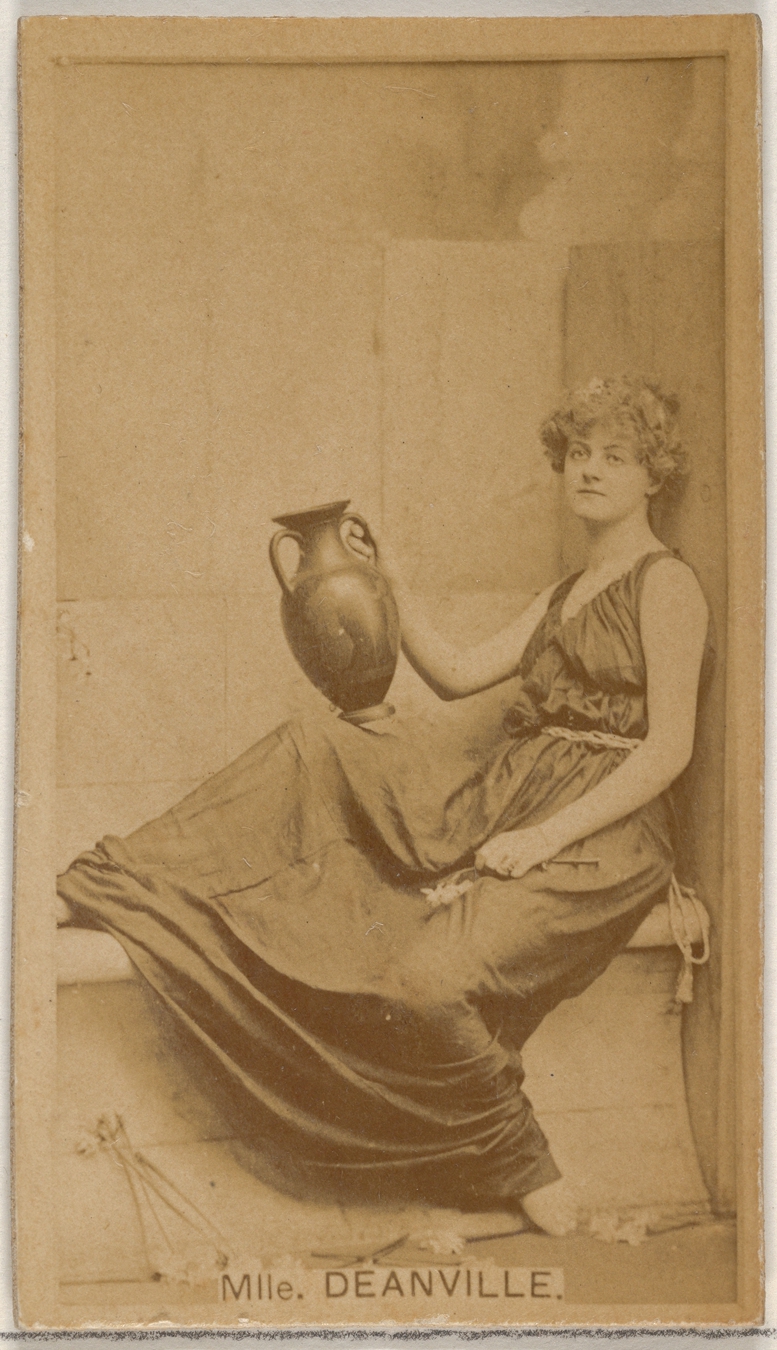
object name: photograph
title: Mlle. Deanville, from the Actors and Actresses series (N45, Type 8) for Virginia Brights Cigarettes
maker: allen & ginter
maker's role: publisher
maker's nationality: american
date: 1888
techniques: albumen silver print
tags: portraits,women,actresses